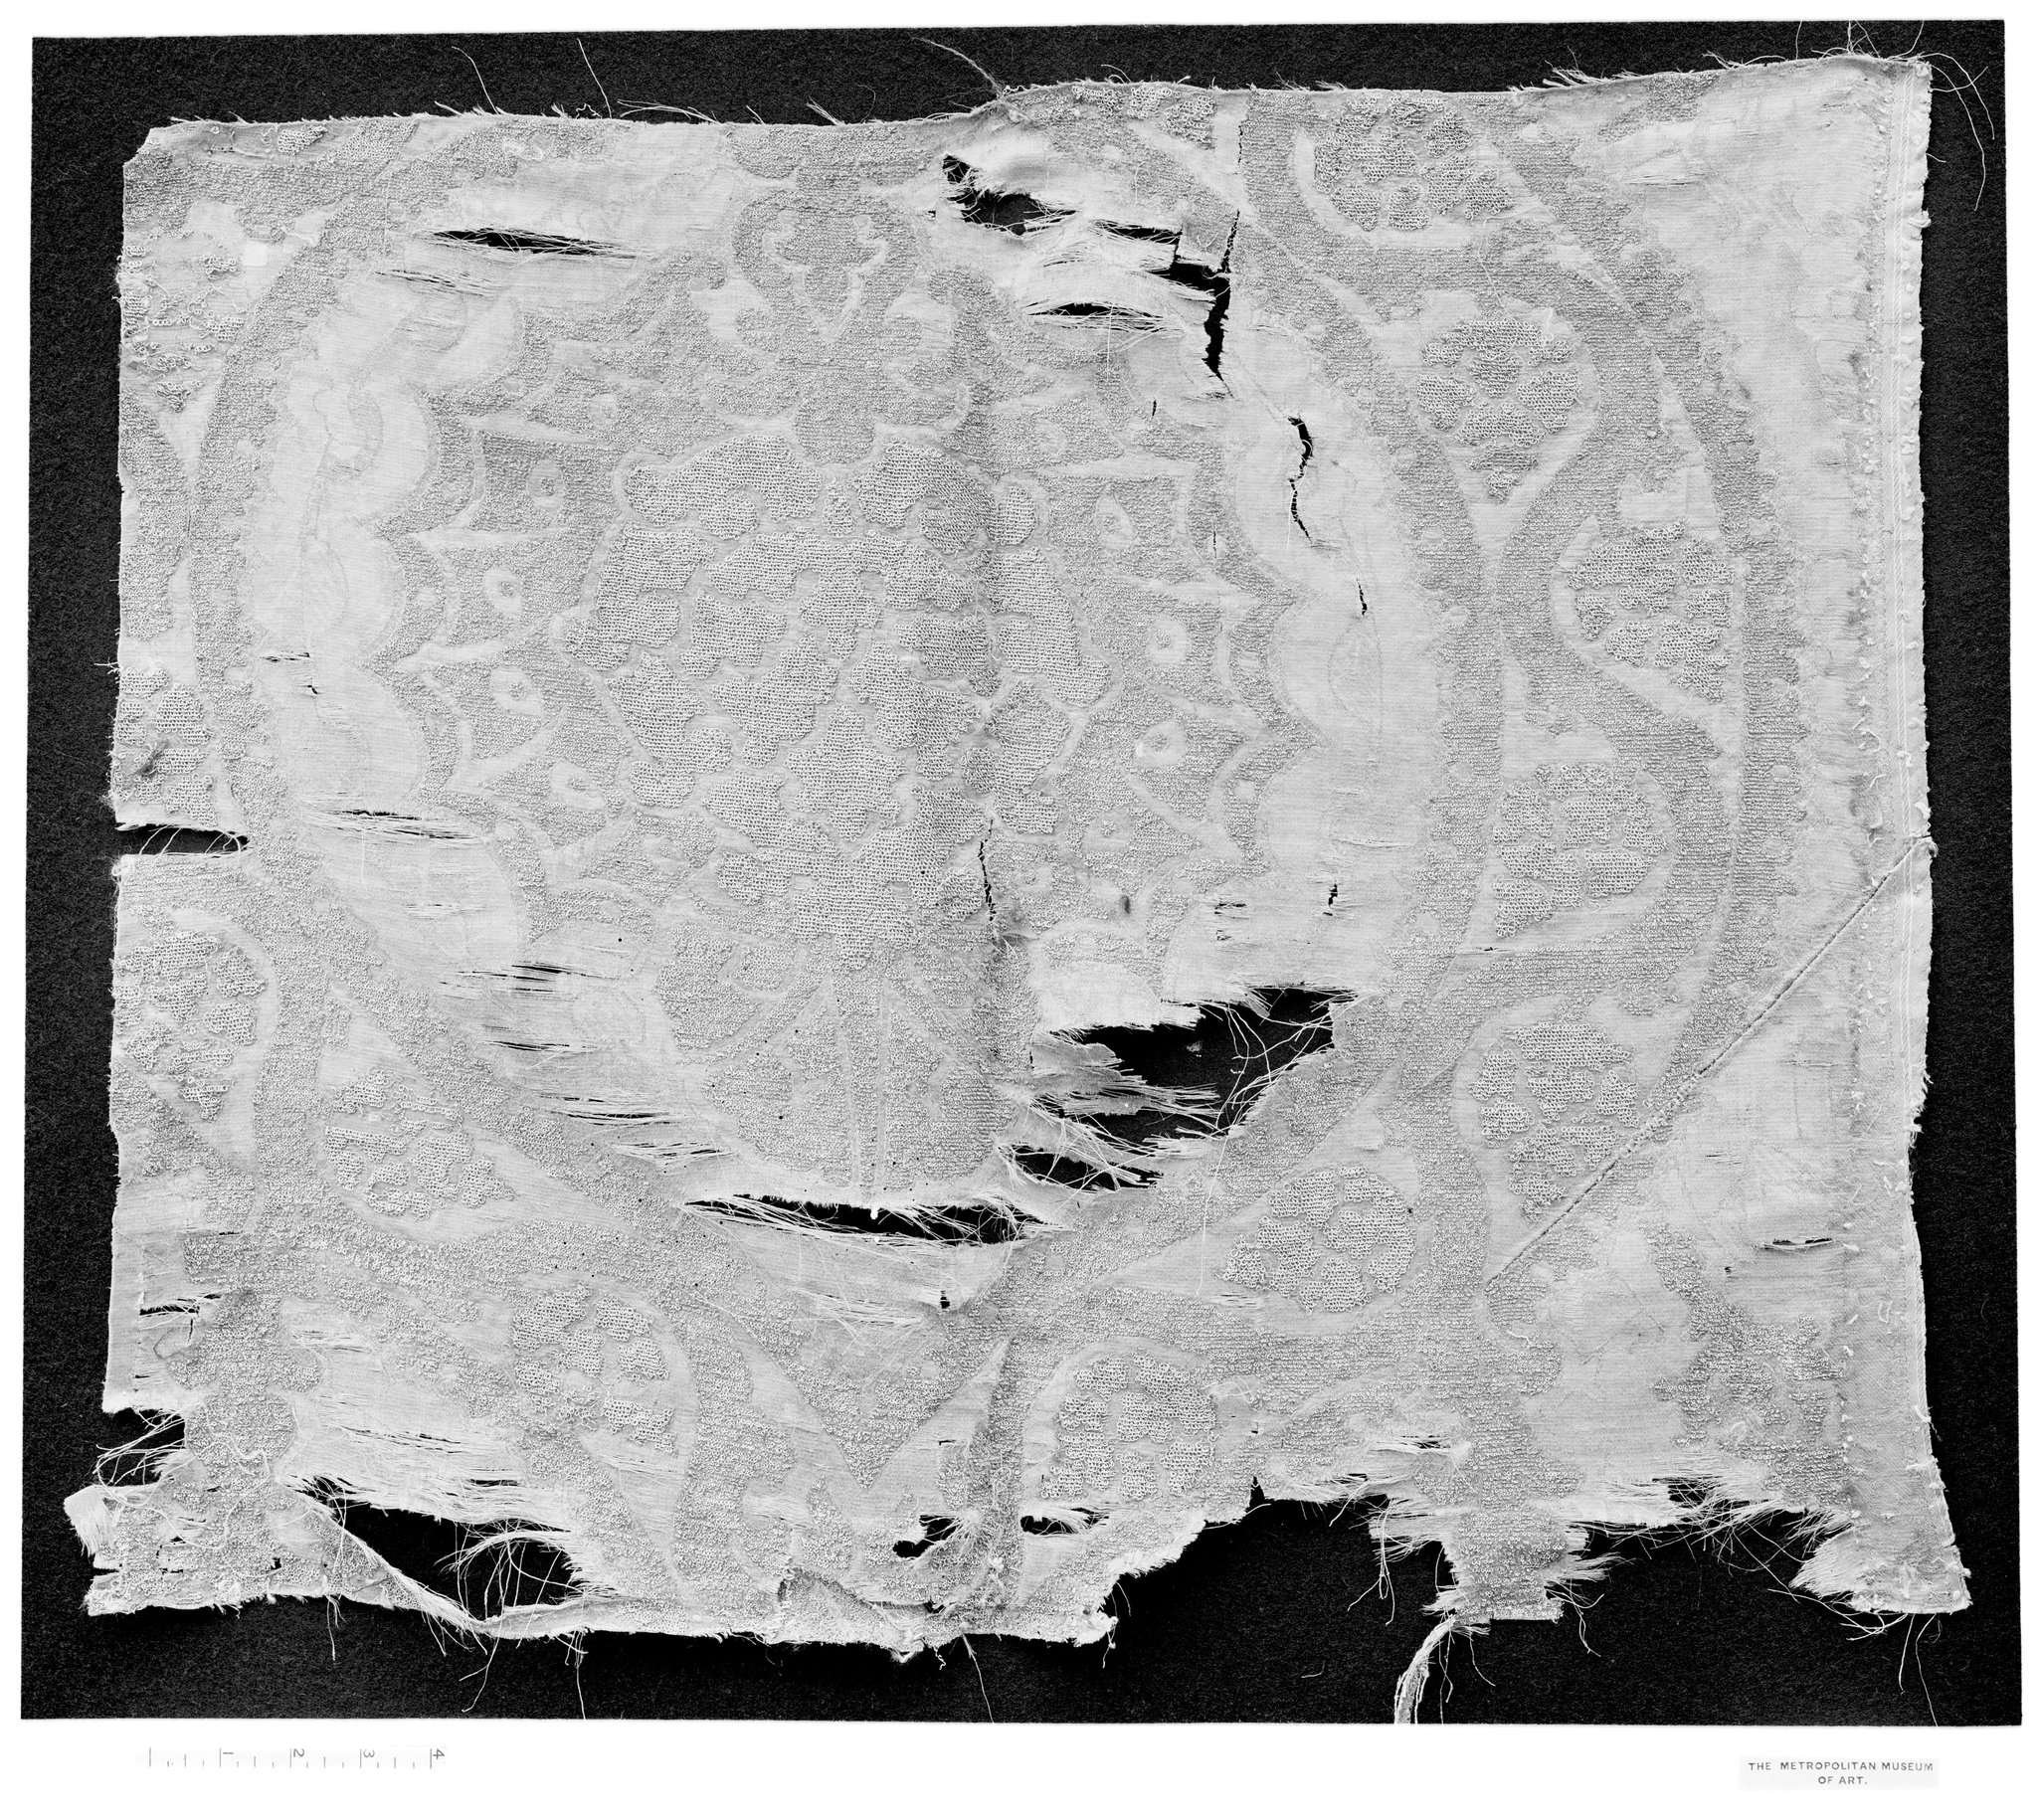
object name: fragment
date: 1501-1600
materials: metal thread, silk